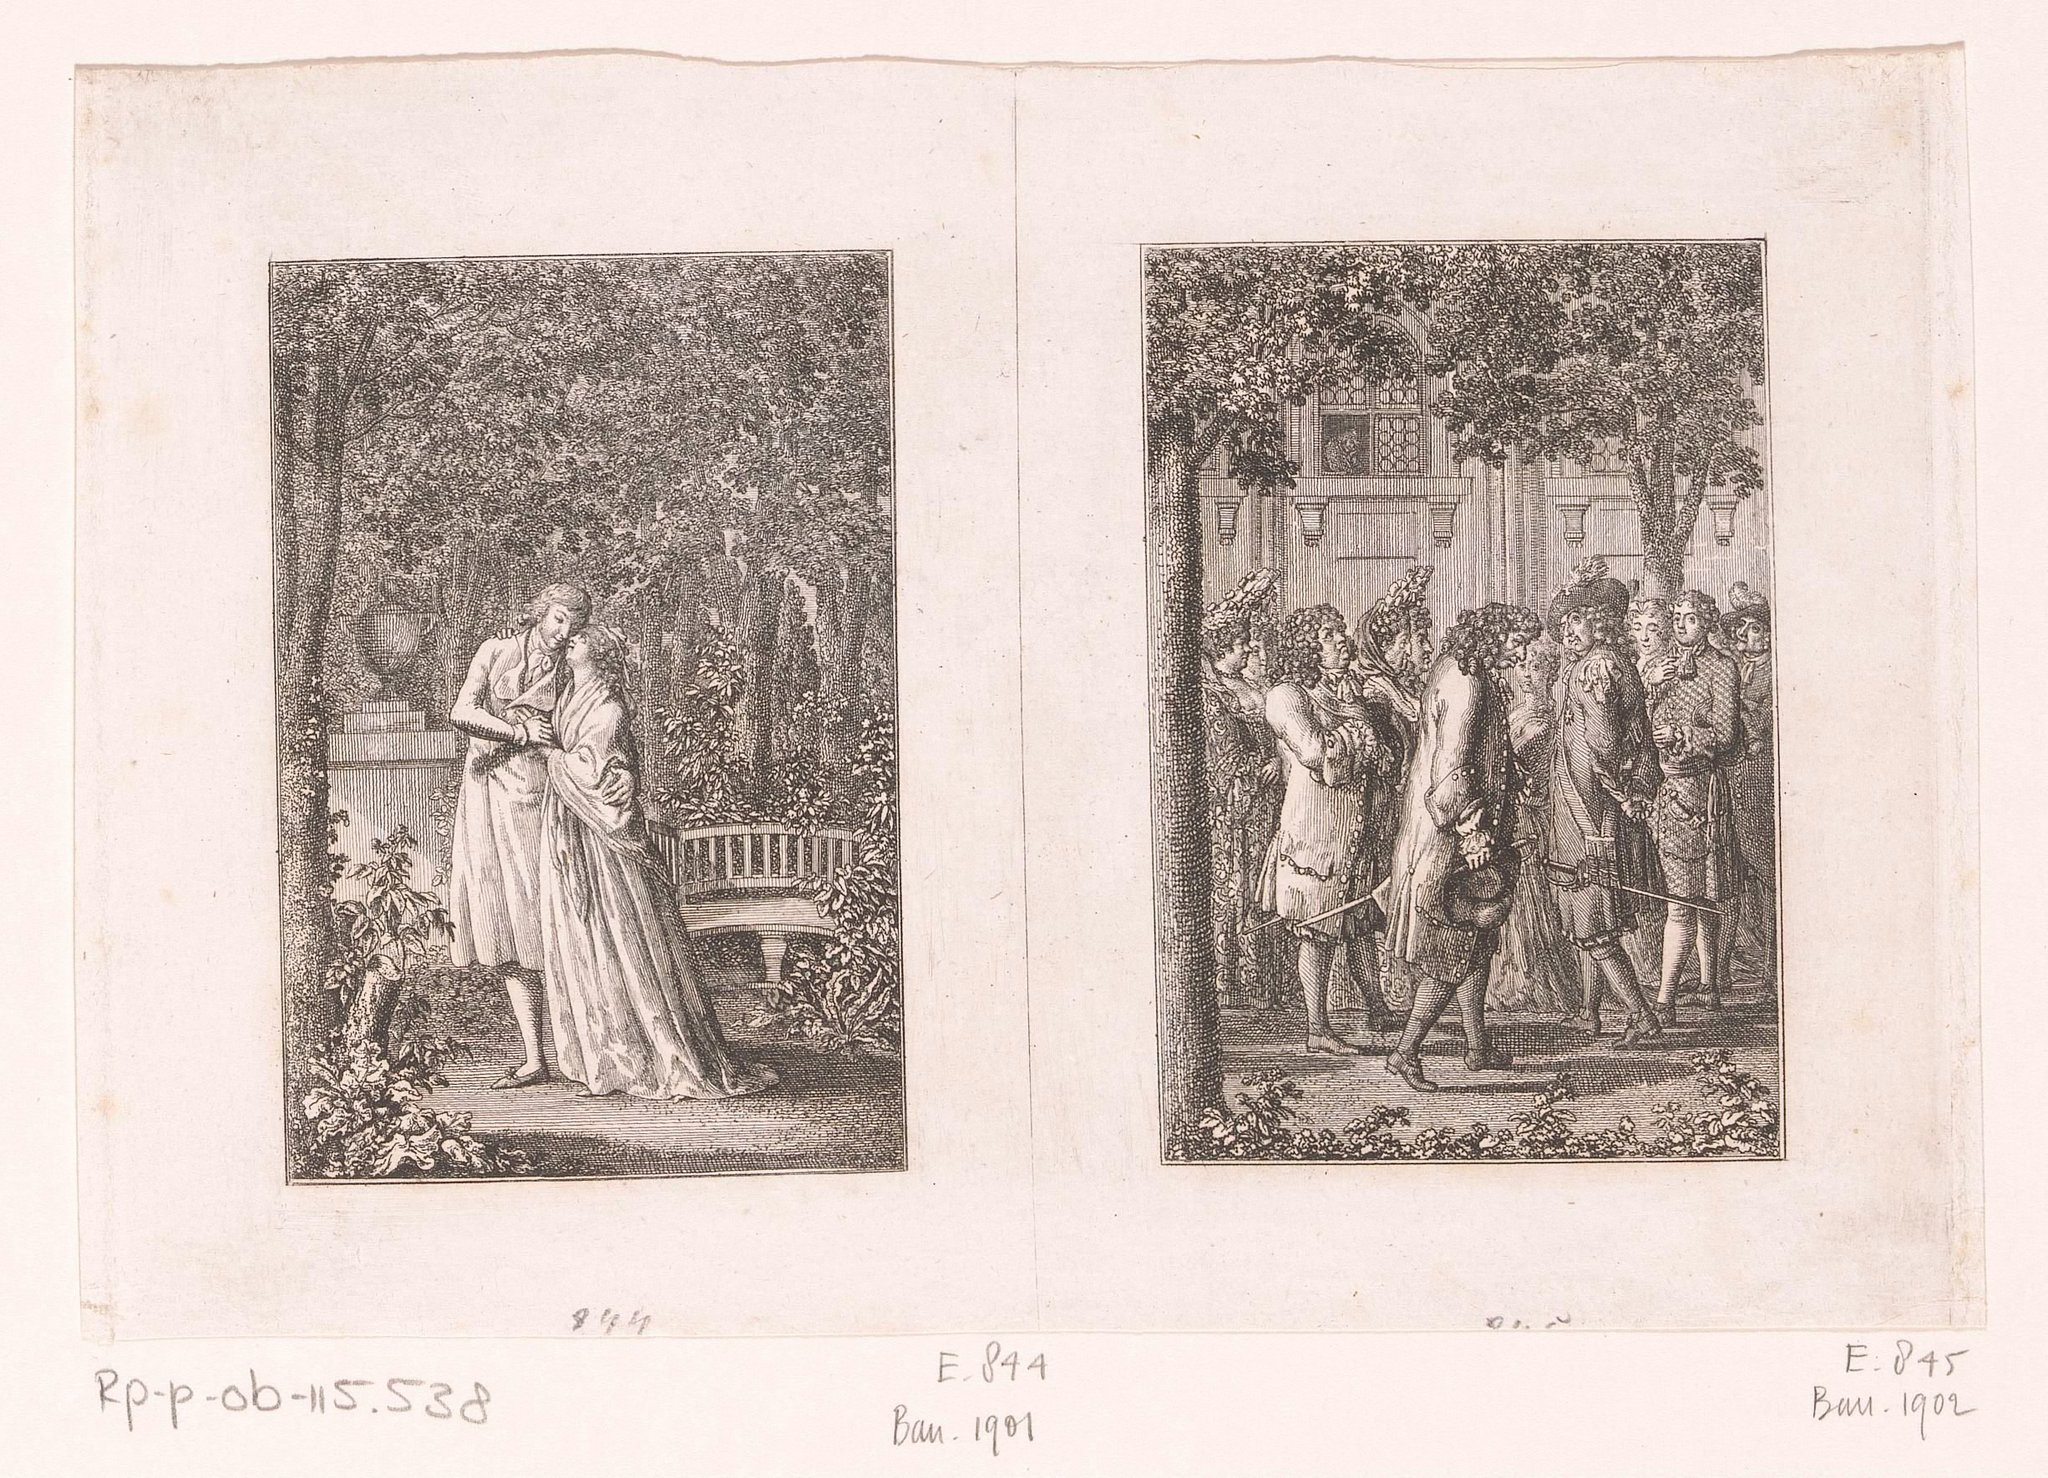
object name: print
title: Twee voorstellingen uit de verhalen van Wilhelm Gottlieb Becker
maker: daniel nikolaus chodowiecki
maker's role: draughtsman, print maker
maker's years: 1726-1801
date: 1797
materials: paper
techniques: etching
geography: berlin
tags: crowd, mob, literature, (lovers) embracing each other, 'symplegma', garden, open window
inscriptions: collector's mark: Lugt 2228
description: Latere staat gebruikt voor: Becker, Wilhelm Gottlieb. Almanach und Taschenbuch zum geselligen Vergnügen von W. G. Becker für 1798. Leipzig: Voss und Comp., [1797].